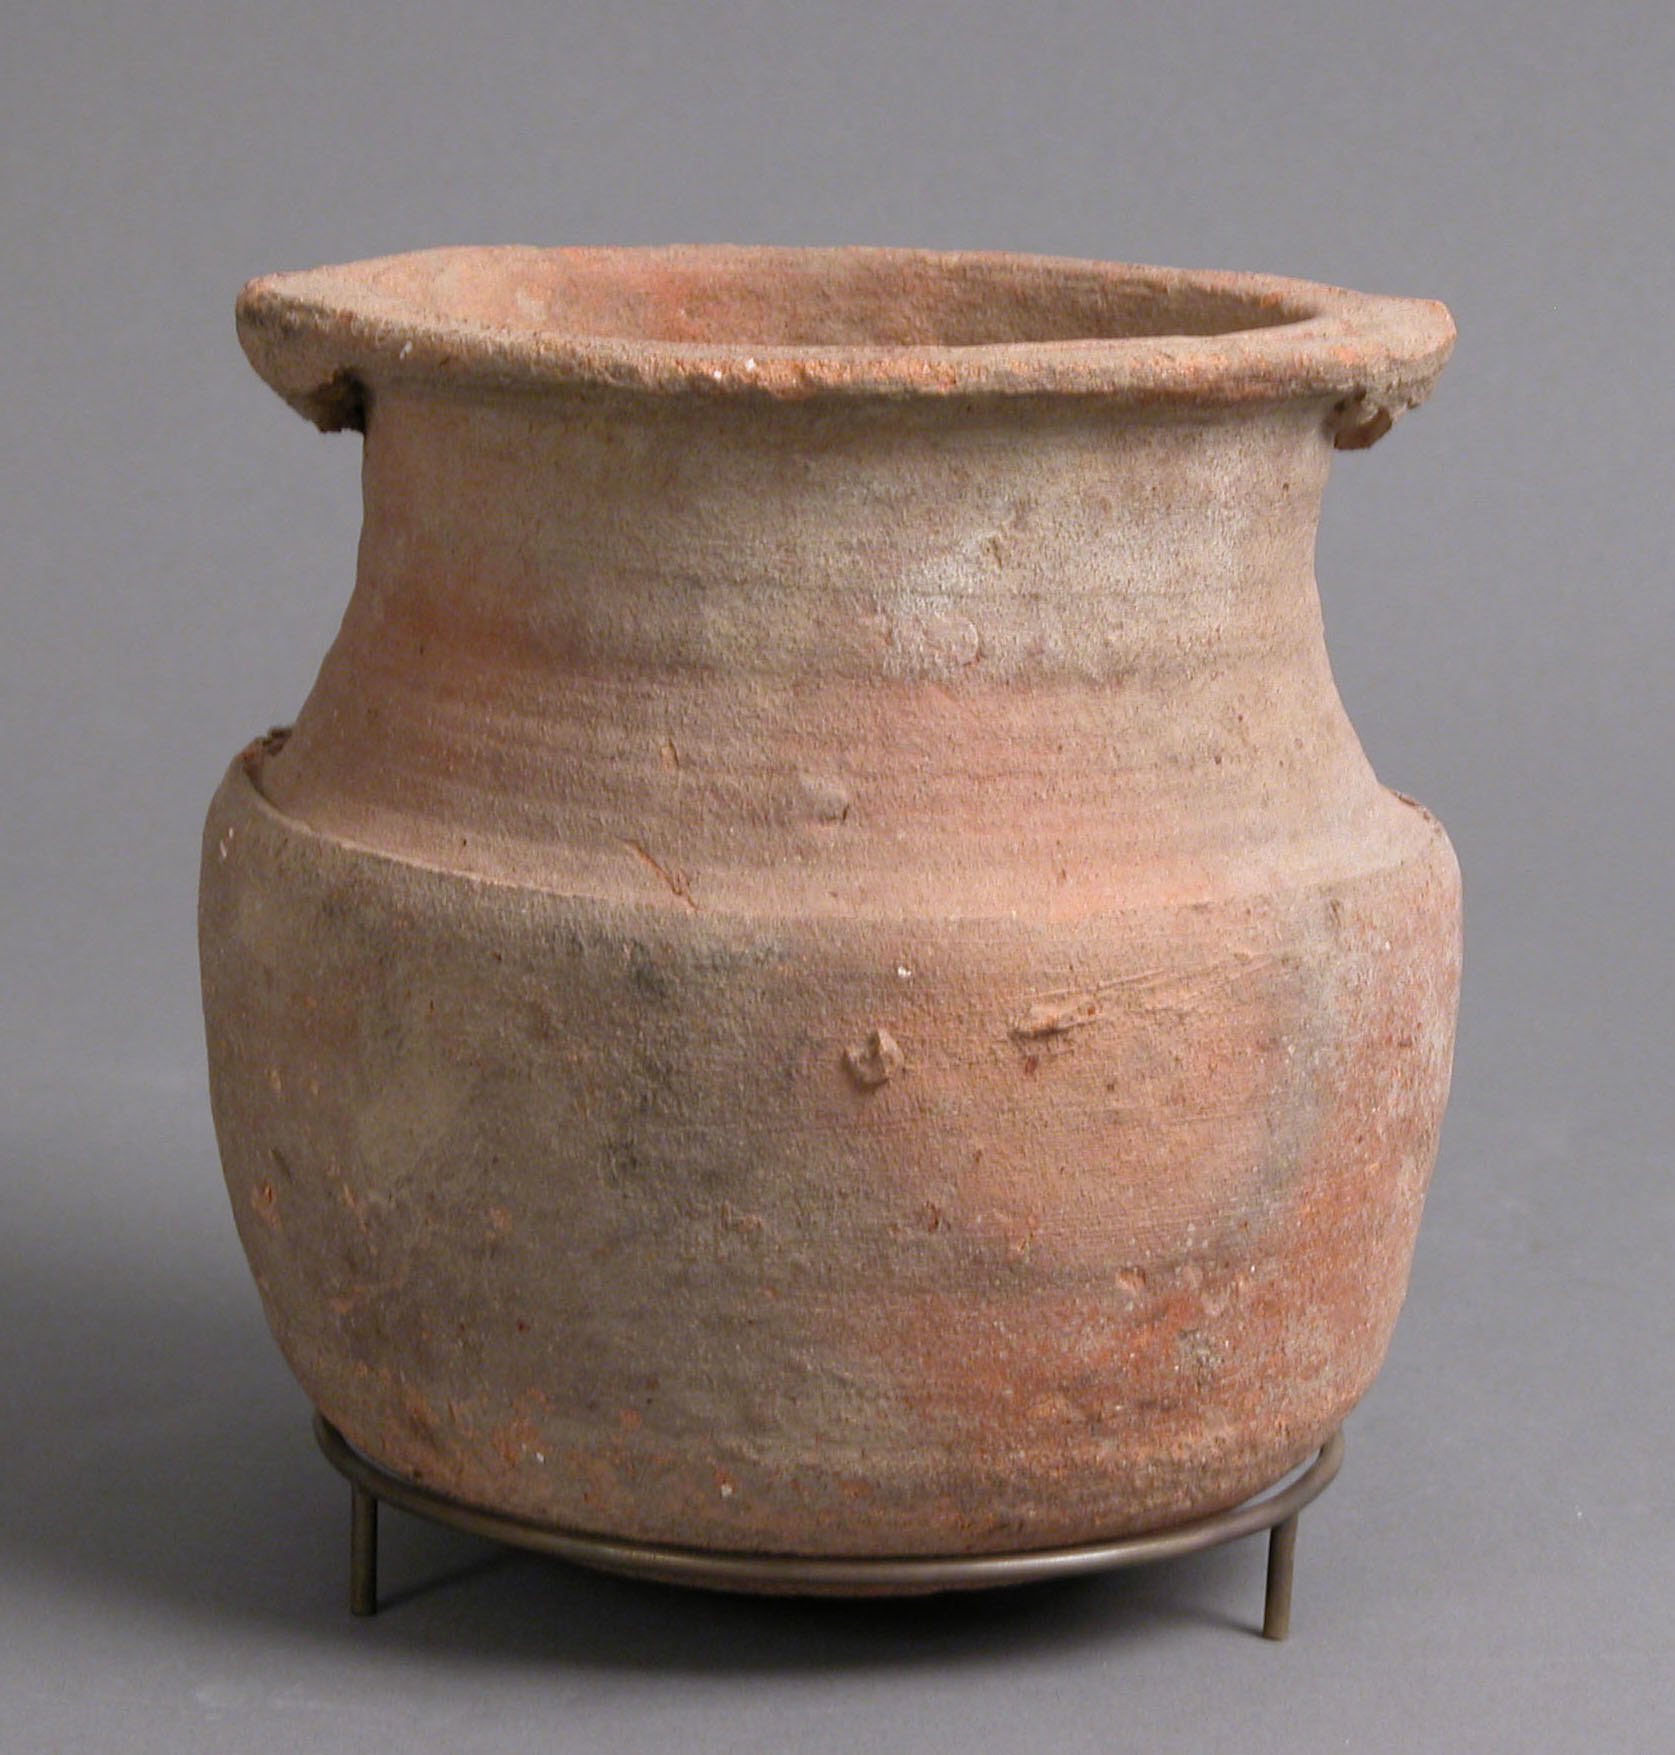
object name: pot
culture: coptic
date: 301-700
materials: earthenware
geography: egypt